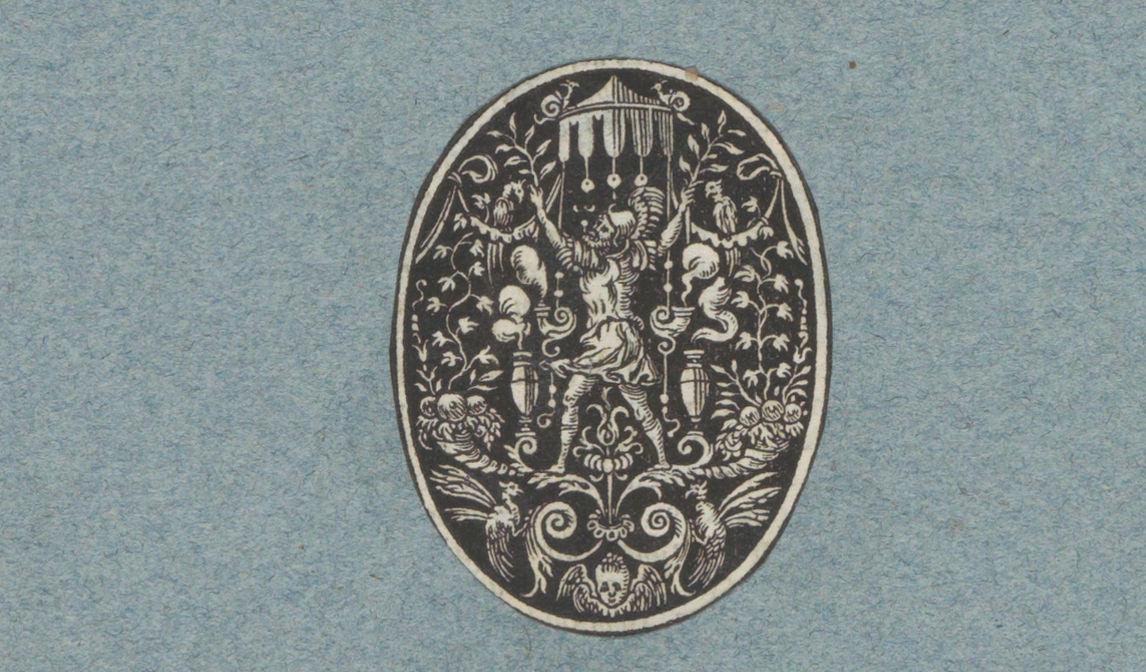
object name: book illustration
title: Mars onder een baldakijn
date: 1628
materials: paper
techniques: woodcut, pasting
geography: amsterdam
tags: 'cornucopia', horn of plenty, (story of) mars (ares), ornamental decoration ~ printed matter, book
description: Ornament uit: Herman Hugo, Pia desideria emblematis, elegiis & affectibus S. S. Patrum illustrata, Antwerpen 1628. Volgens de titelpagina verscheen dit werk in Antwerpen bij Hendrick Aertssens, in werkelijkheid verscheen het in Amsterdam bij Pieter Jacobsz Paets (Dietz 2012, p. 58-59).